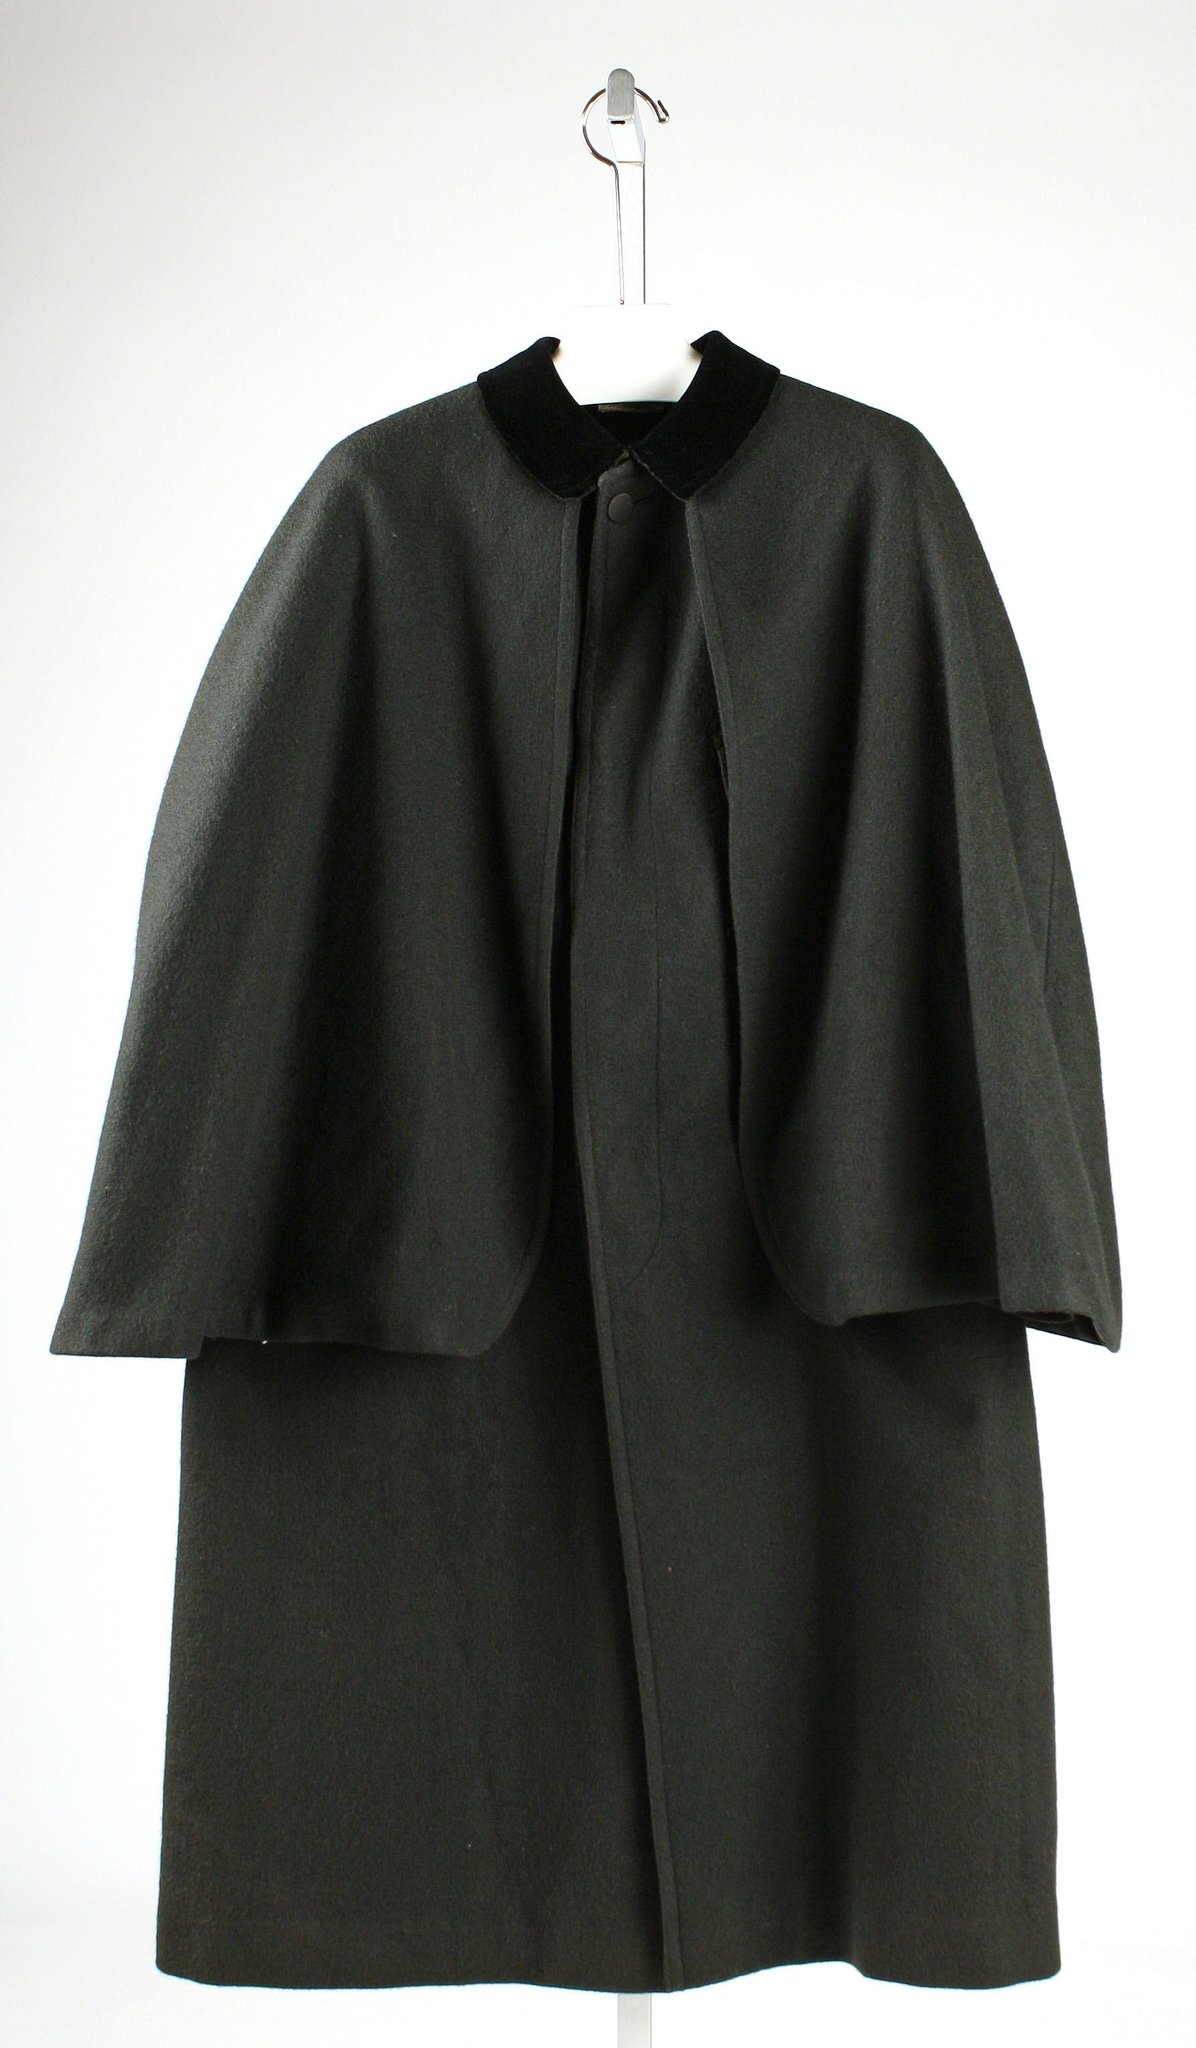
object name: coat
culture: american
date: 1890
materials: wool